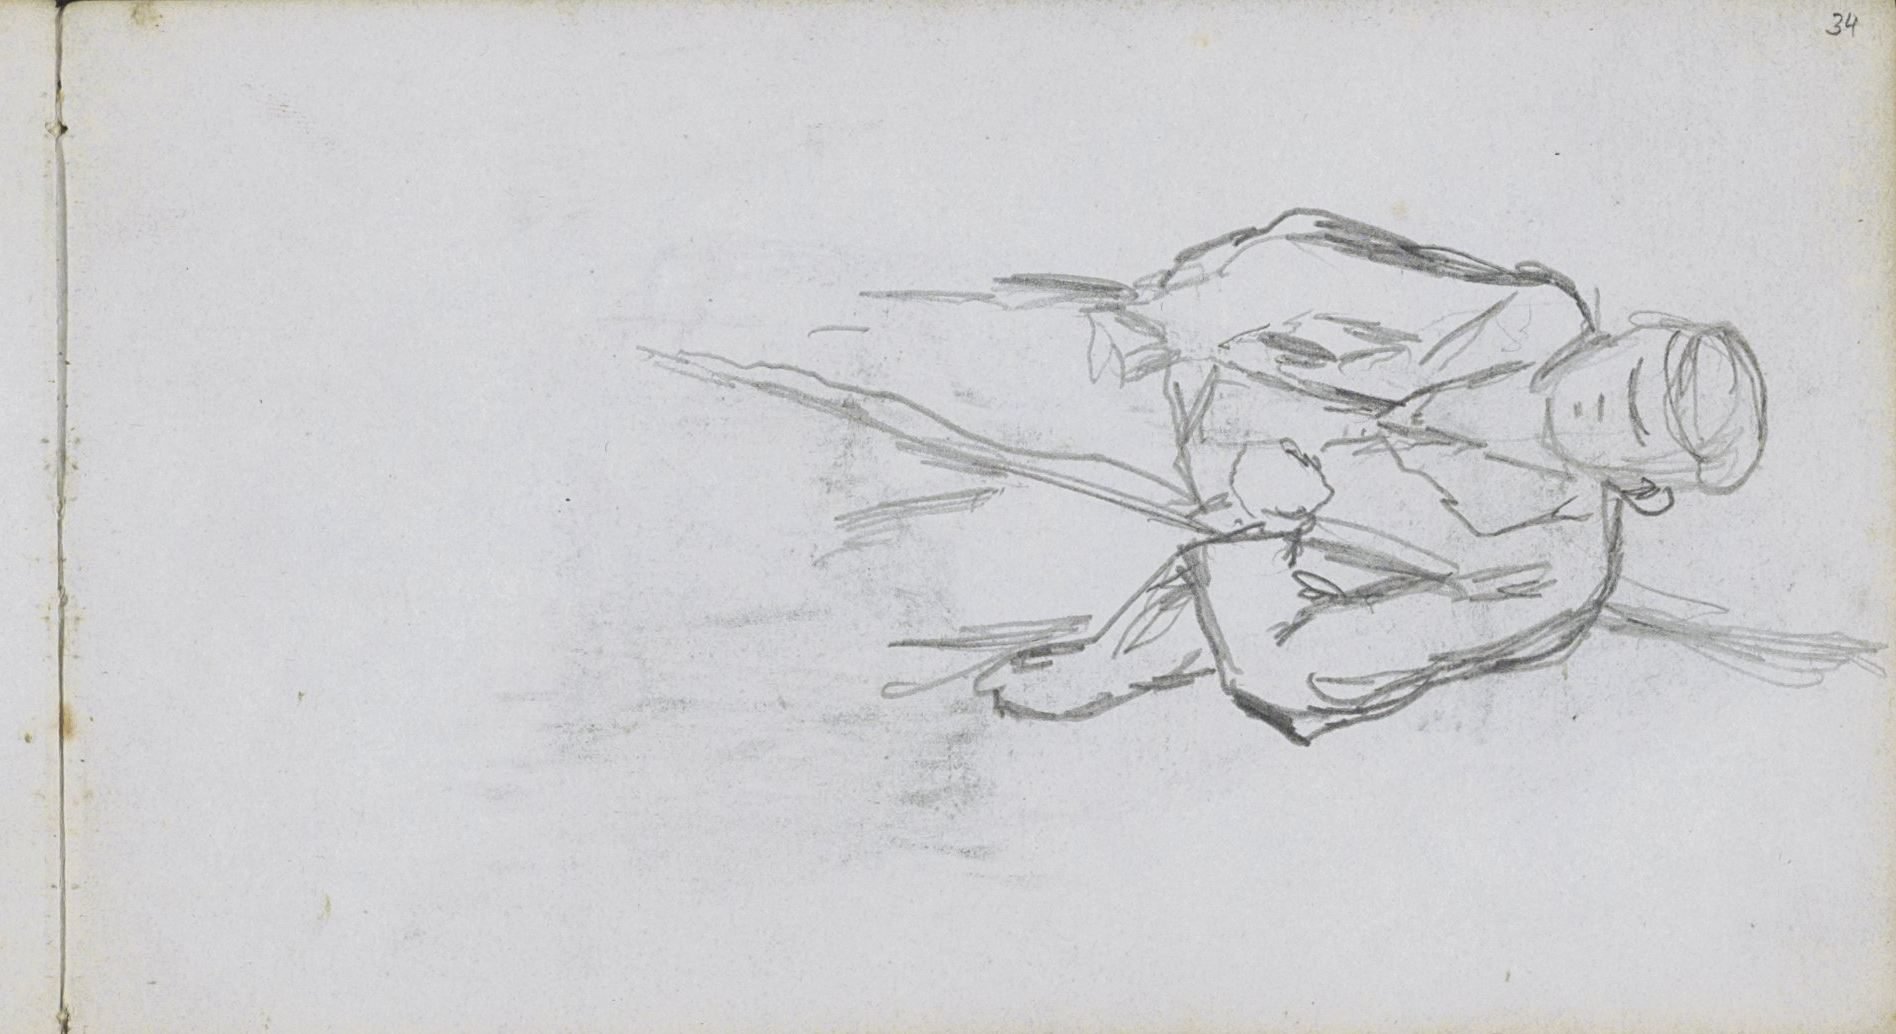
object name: sketchbook leaf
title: Man met een pet en stok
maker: johan hendrik weissenbruch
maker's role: draughtsman, painter, print maker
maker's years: 1824-1903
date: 1834-1903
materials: paper, pencil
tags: walking-stick, staff, adult man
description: Blad 34 recto uit een schetsboek met 39 bladen.